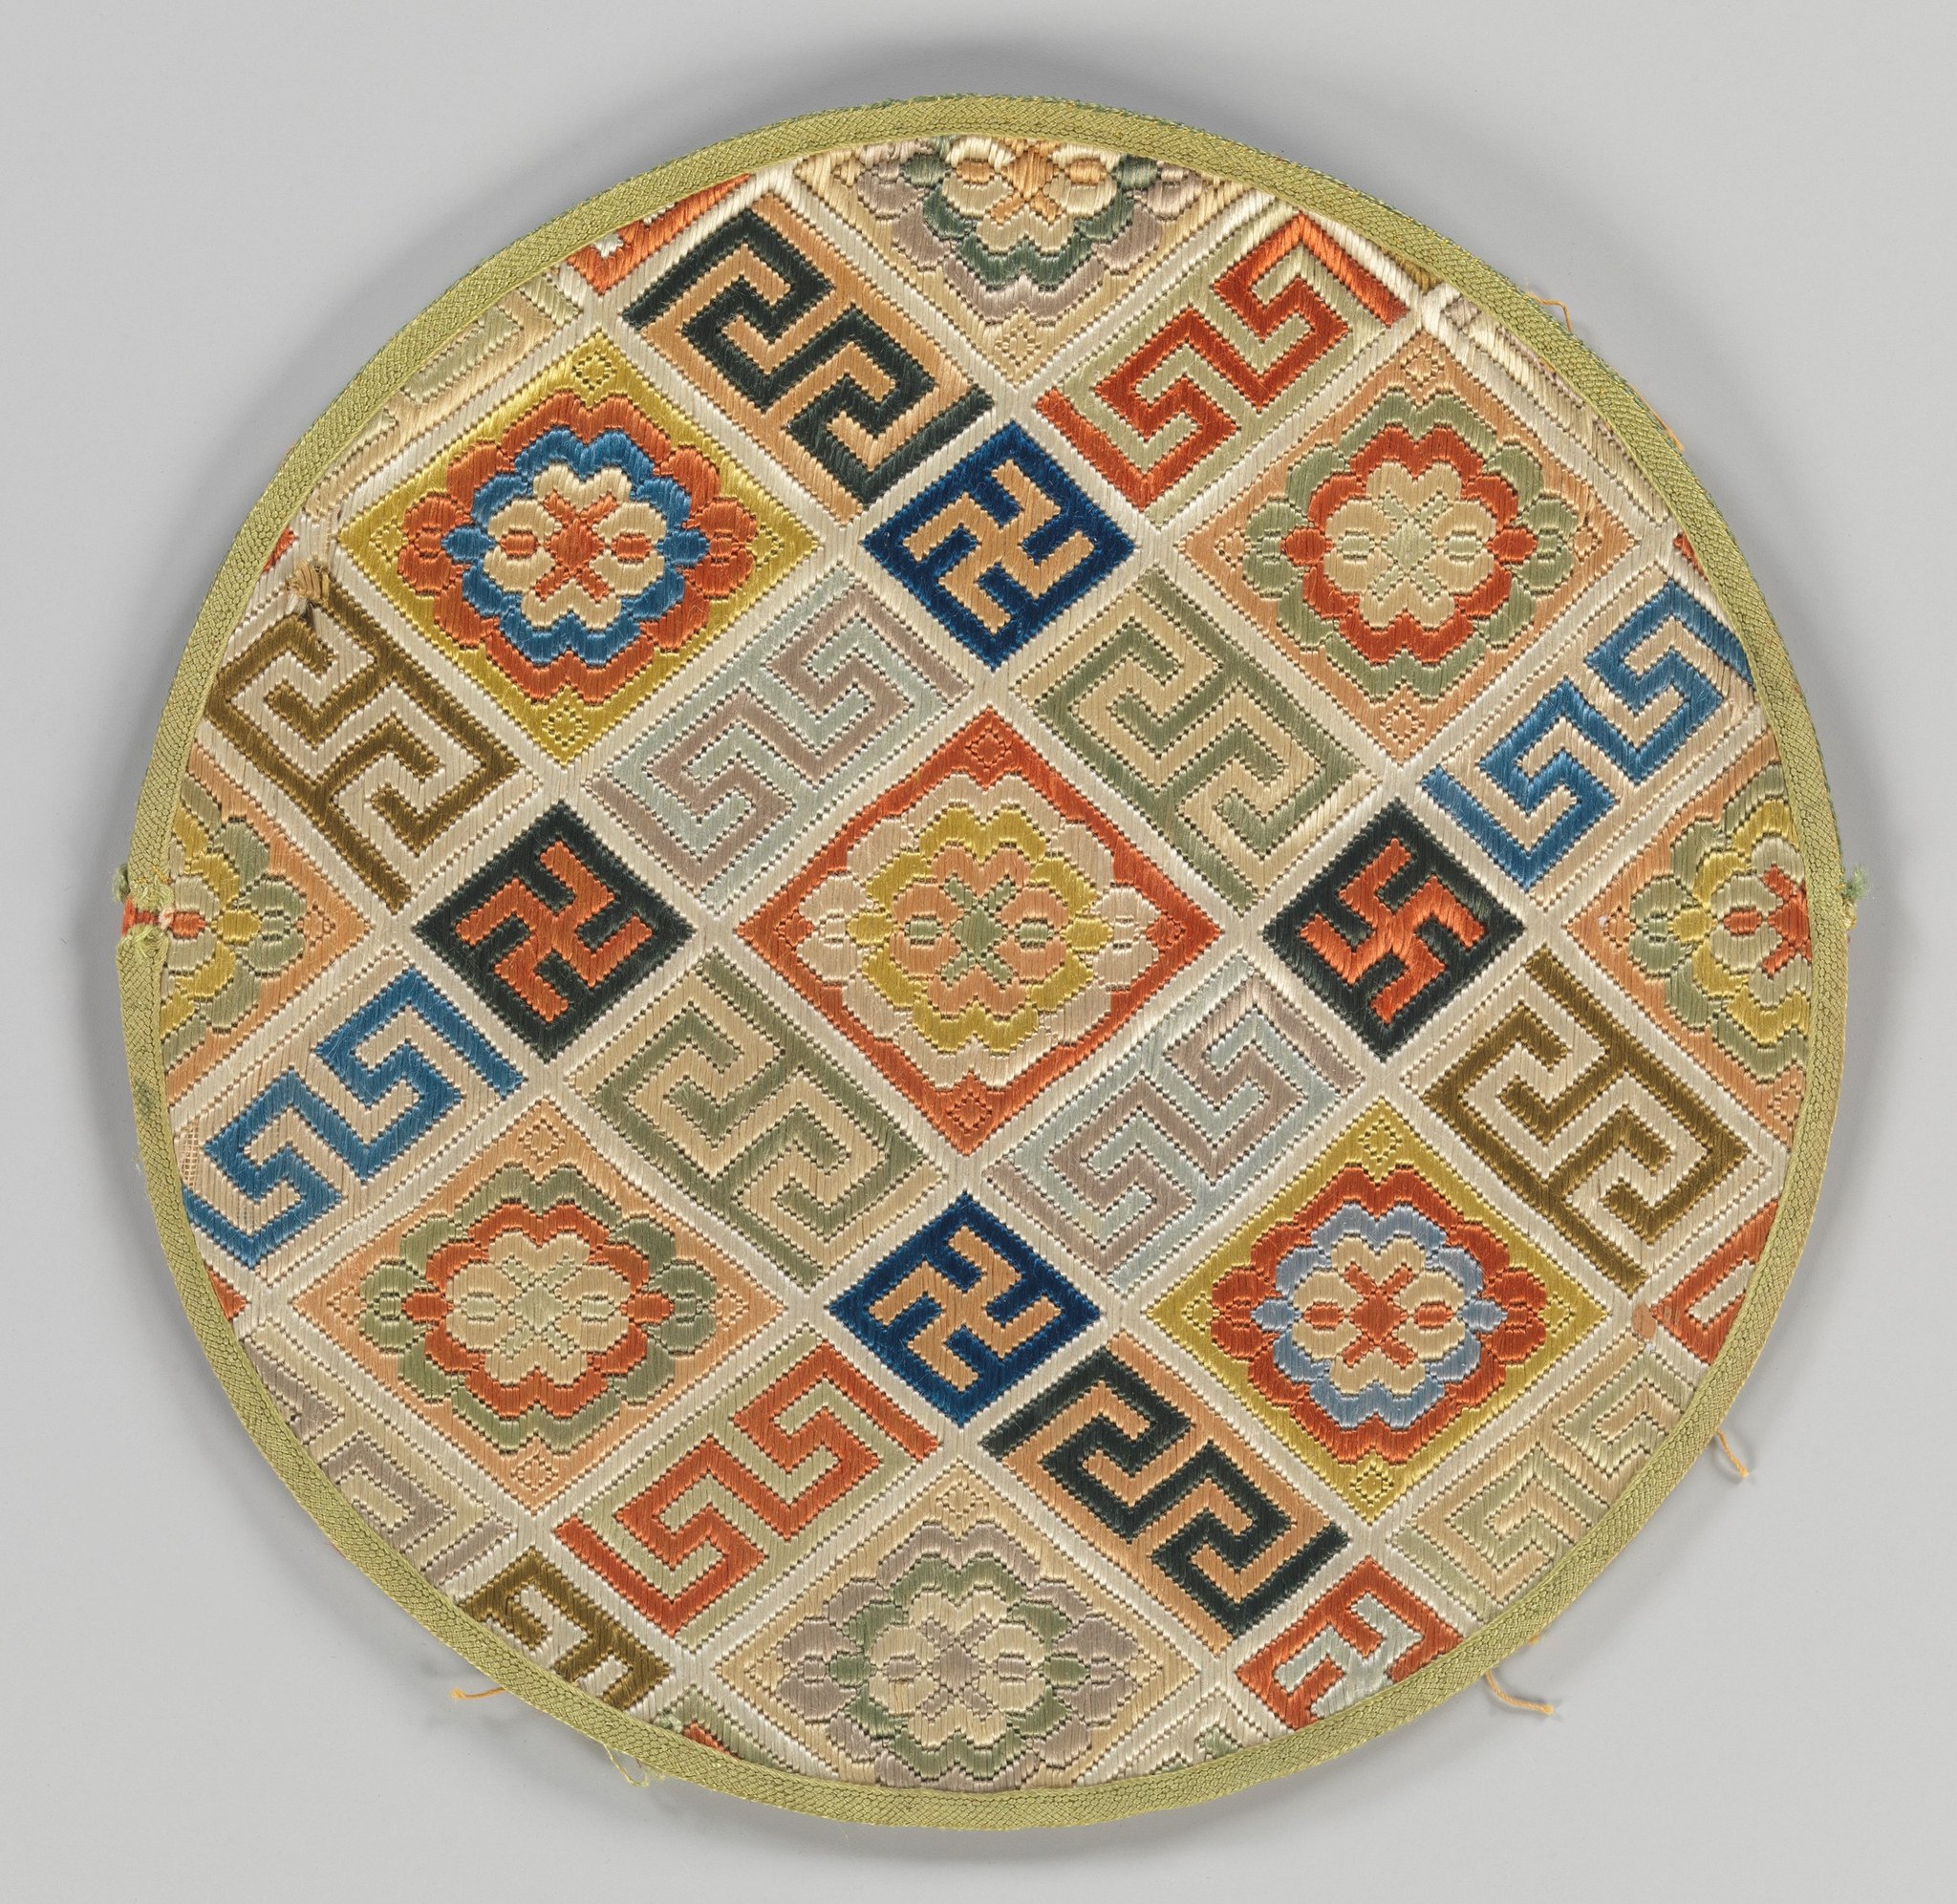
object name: mirror case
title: Mirror Case with Filled Diagonal Lattice and Swastikas (Wan)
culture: chinese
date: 1644-1911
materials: textile, silk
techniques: embroidery